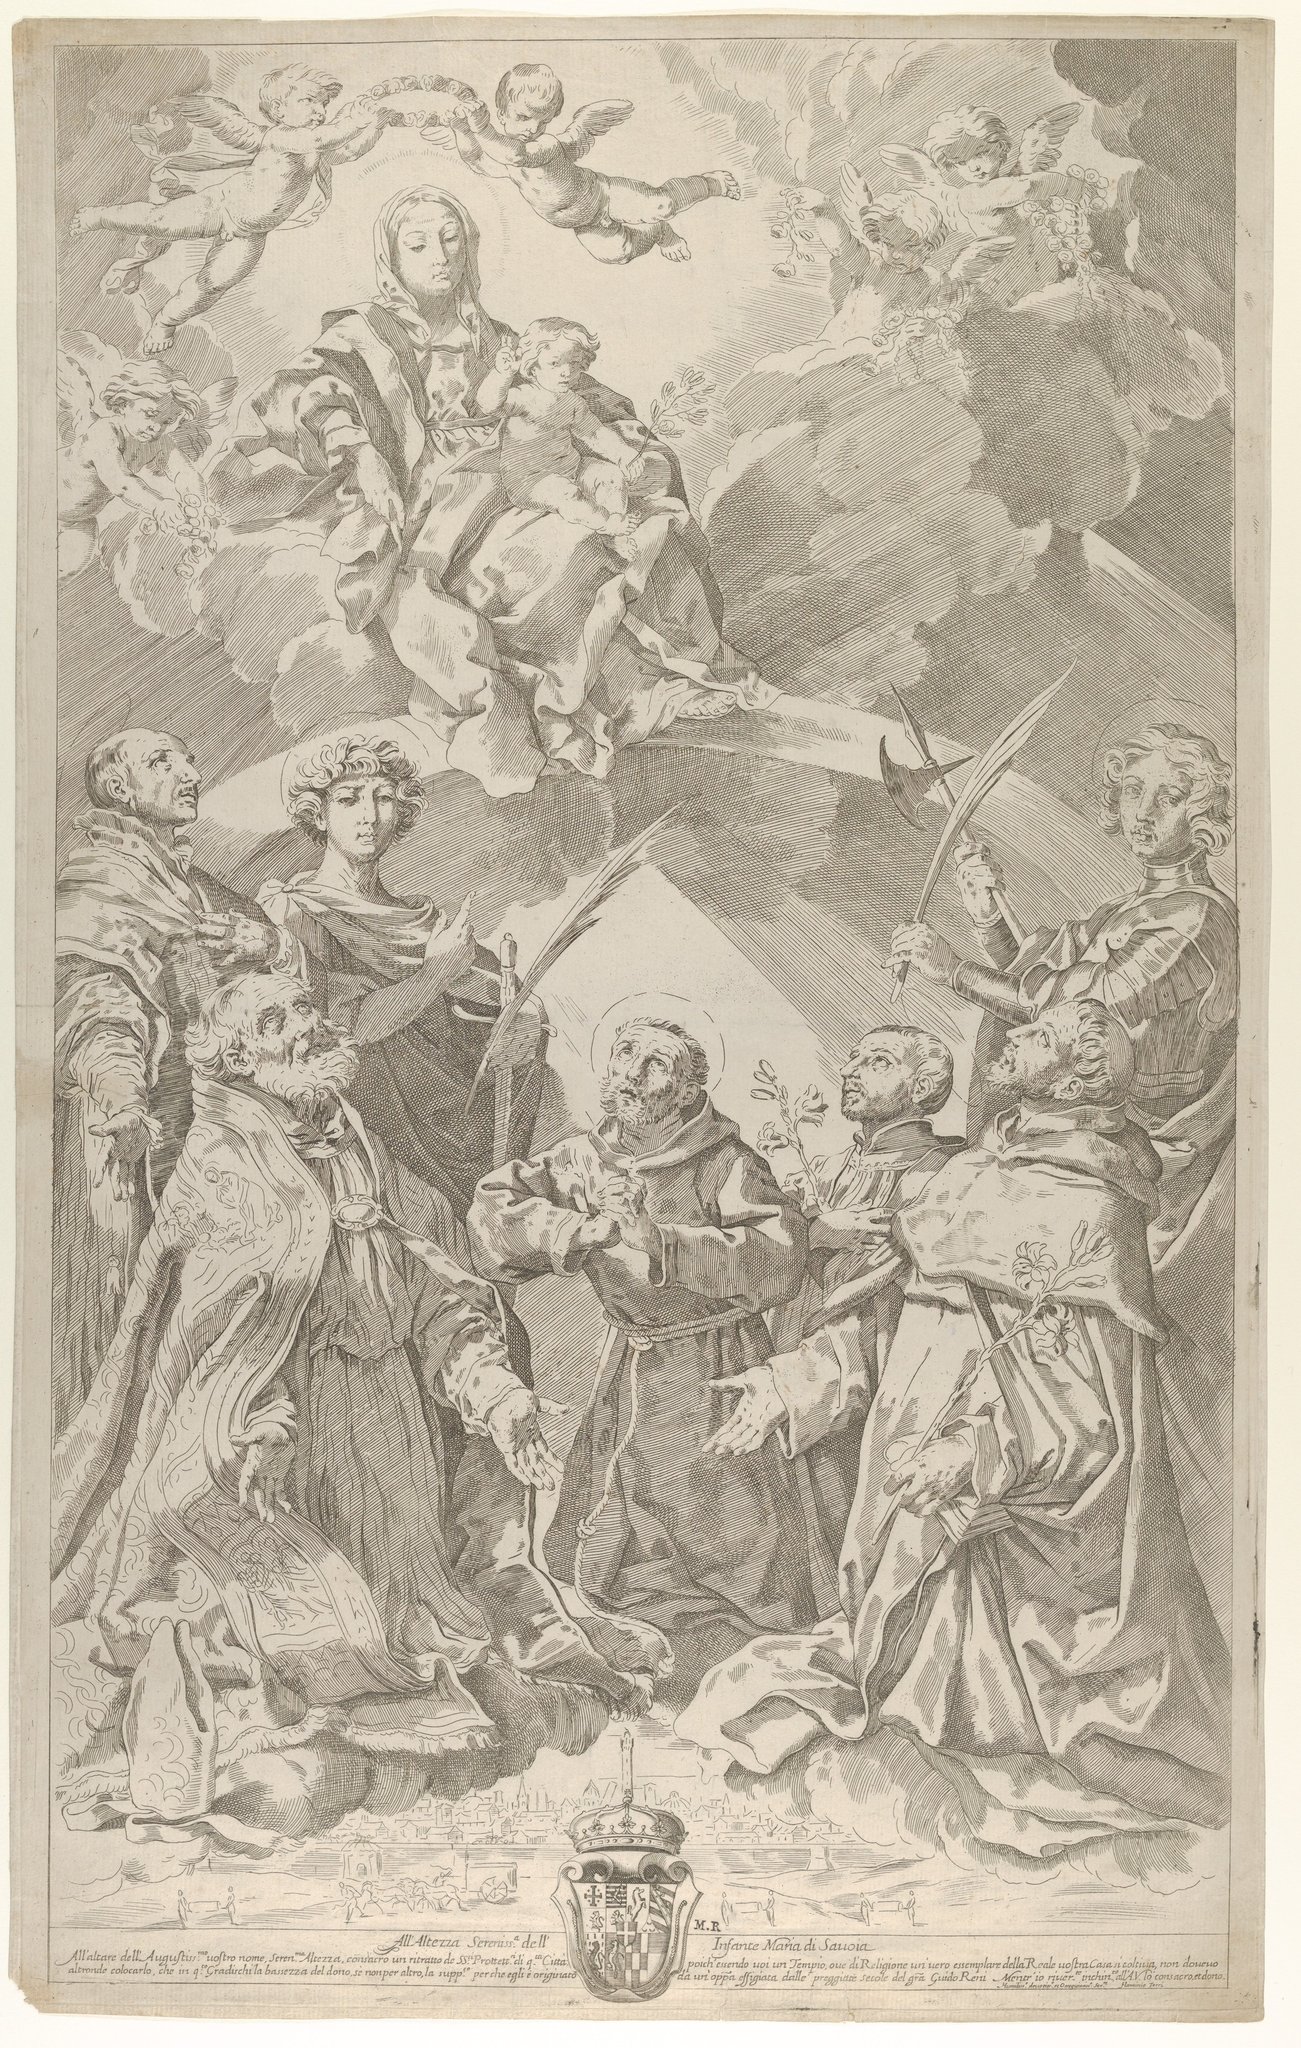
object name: print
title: Patron saints of Bologna looking upwards at the Virgin who is seated in the clouds with the infant Christ on her lap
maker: flaminio torre (torri)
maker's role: artist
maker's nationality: italian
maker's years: 1620-1661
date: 1640-1650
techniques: etching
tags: men,putti,christ,virgin mary,saints,coat of arms